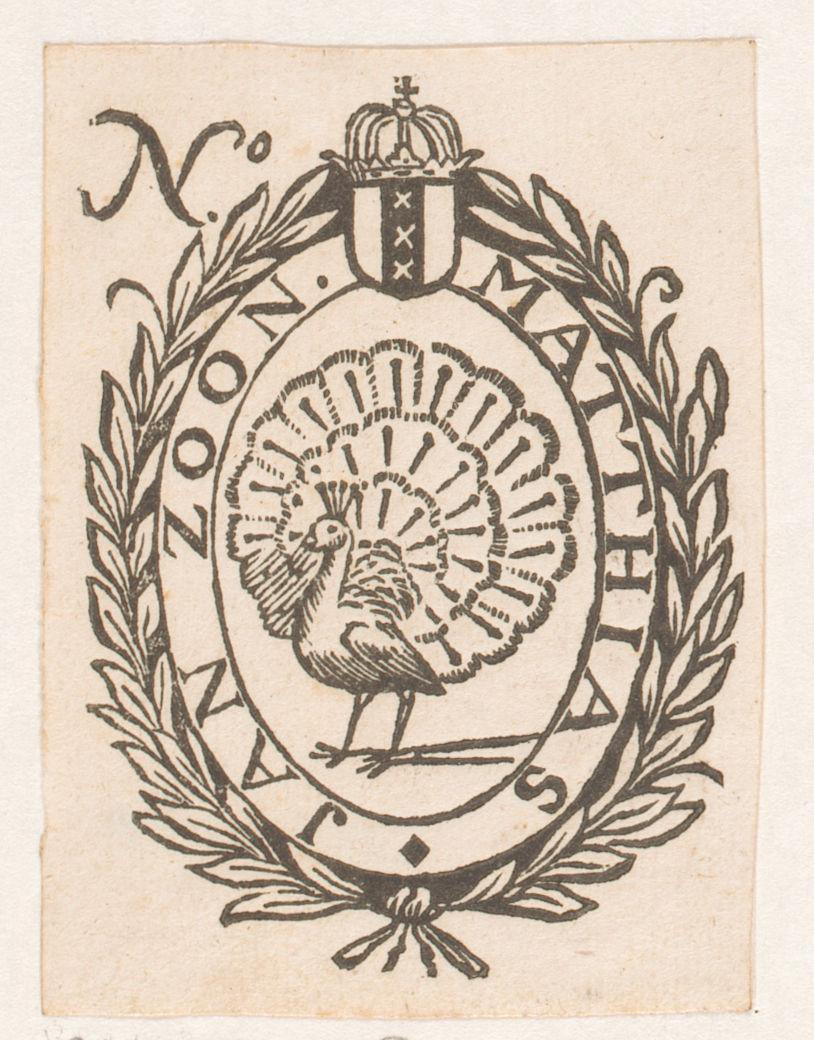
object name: print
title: Vignet met een pauw en het wapen van de stad Amsterdam met een kroon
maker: Anonymous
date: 1600-1699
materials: paper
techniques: woodcut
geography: netherlands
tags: coat of arms (as symbol of the state, etc.) (+ city; municipal), ornamental birds: peacock, vignette, amsterdam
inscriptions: collector's mark: Lugt 240